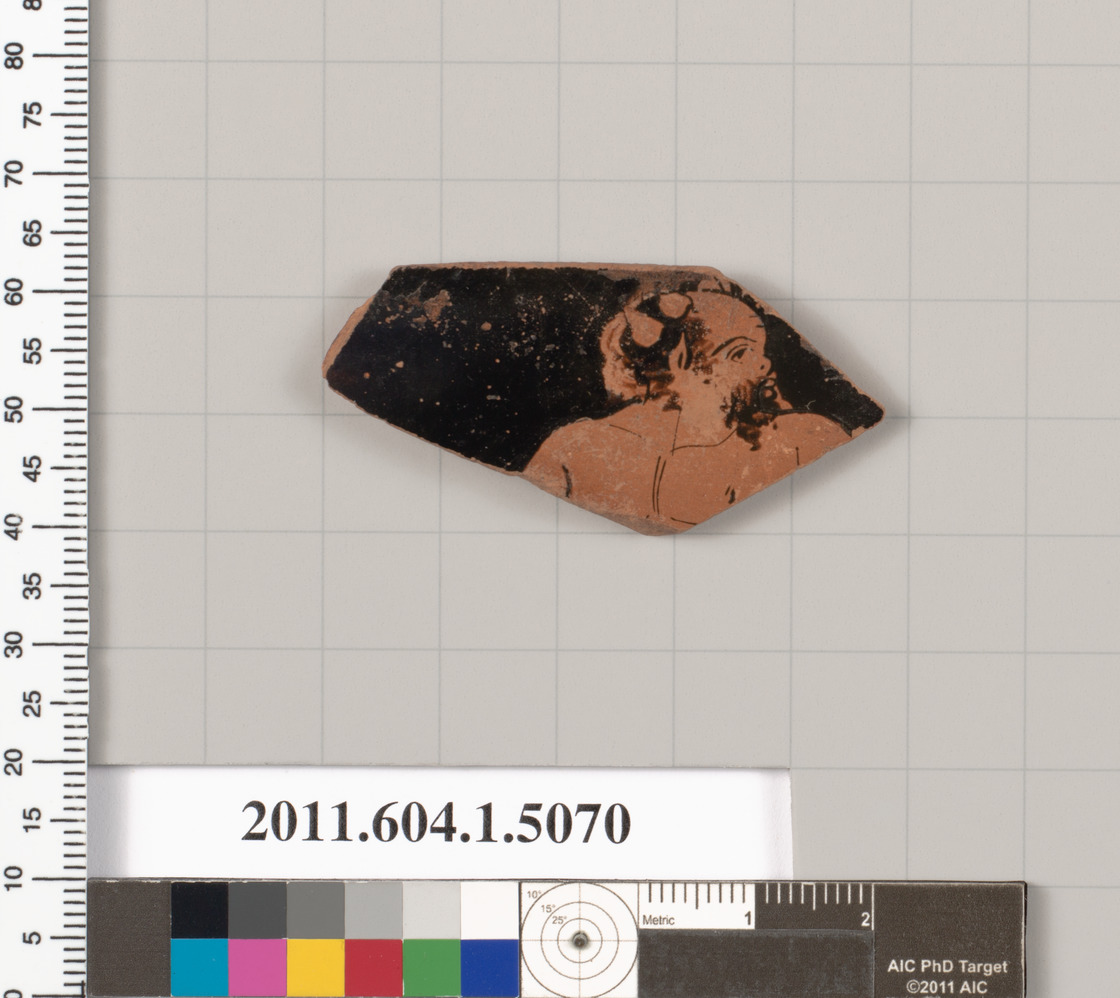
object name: kylix fragment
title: Terracotta rim fragment of a kylix (drinking cup)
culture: greek, attic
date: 450-426 BCE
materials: terracotta